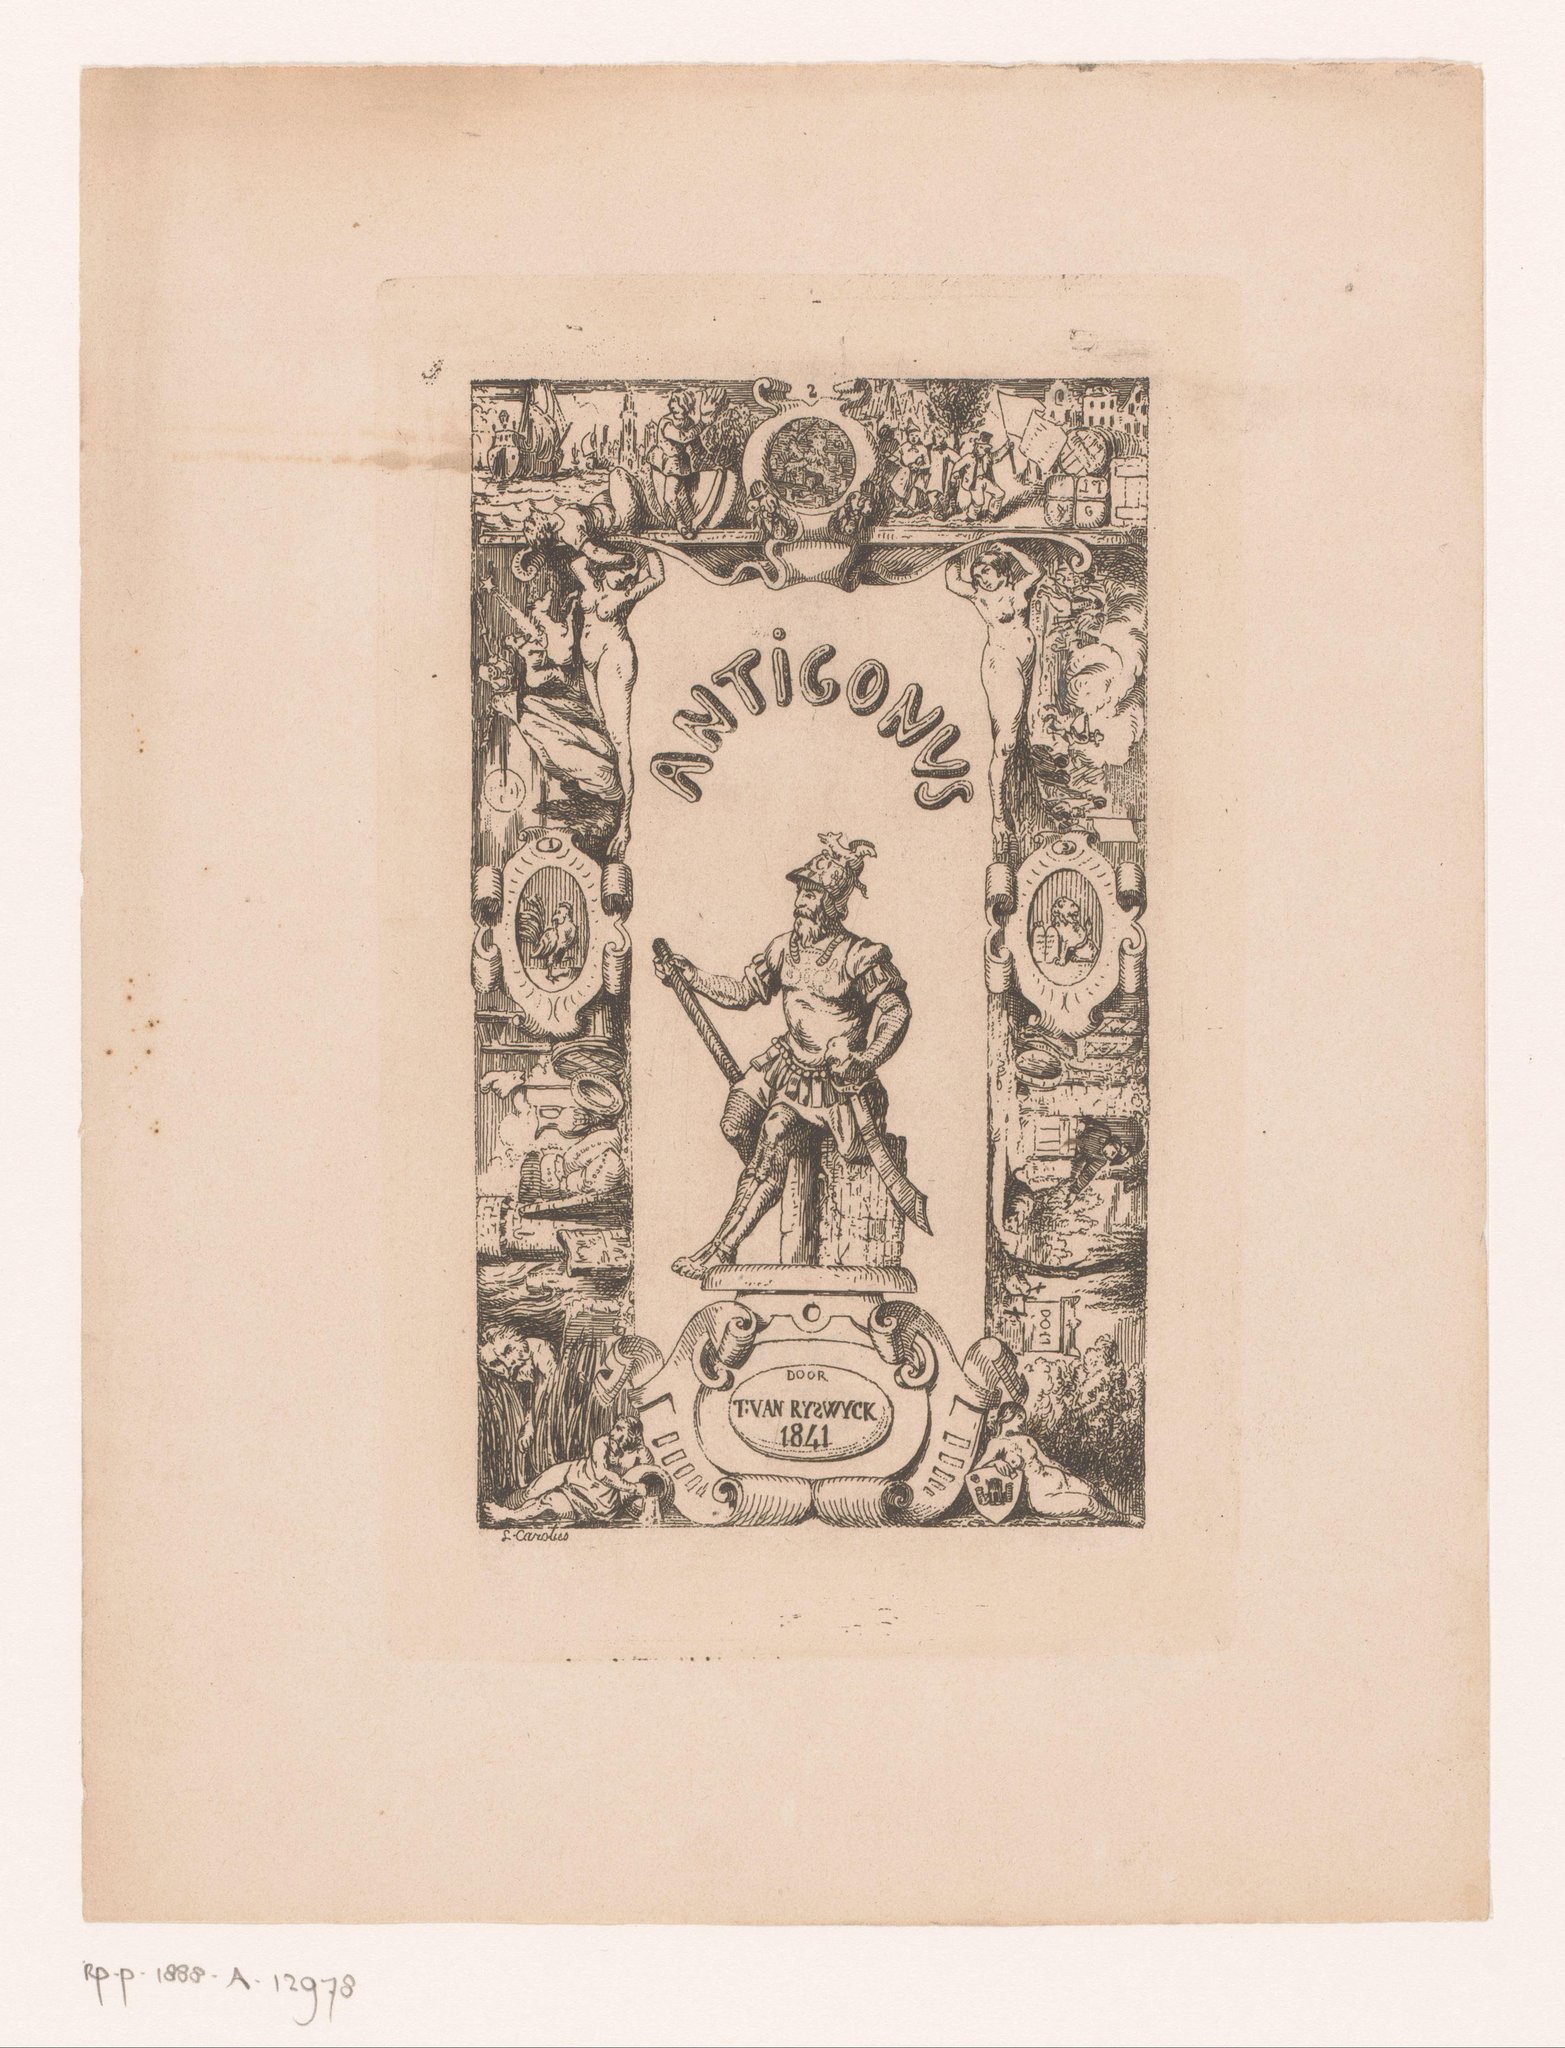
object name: print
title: Titelpagina voor: Theodoor van Rijswijck, Antigonus of de volksklagten, 1841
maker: louis antoine carolus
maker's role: print maker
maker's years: 1814-1865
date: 1841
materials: paper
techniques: etching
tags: commander-in-chief, general, marshal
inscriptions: collector's mark: Lugt 2228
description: Prent uit: Rijswijck, Theodoor van. Antigonus of de volksklagten. Antwerpen: Gebroeders Dewever, 1841, tegenover titelpagina.